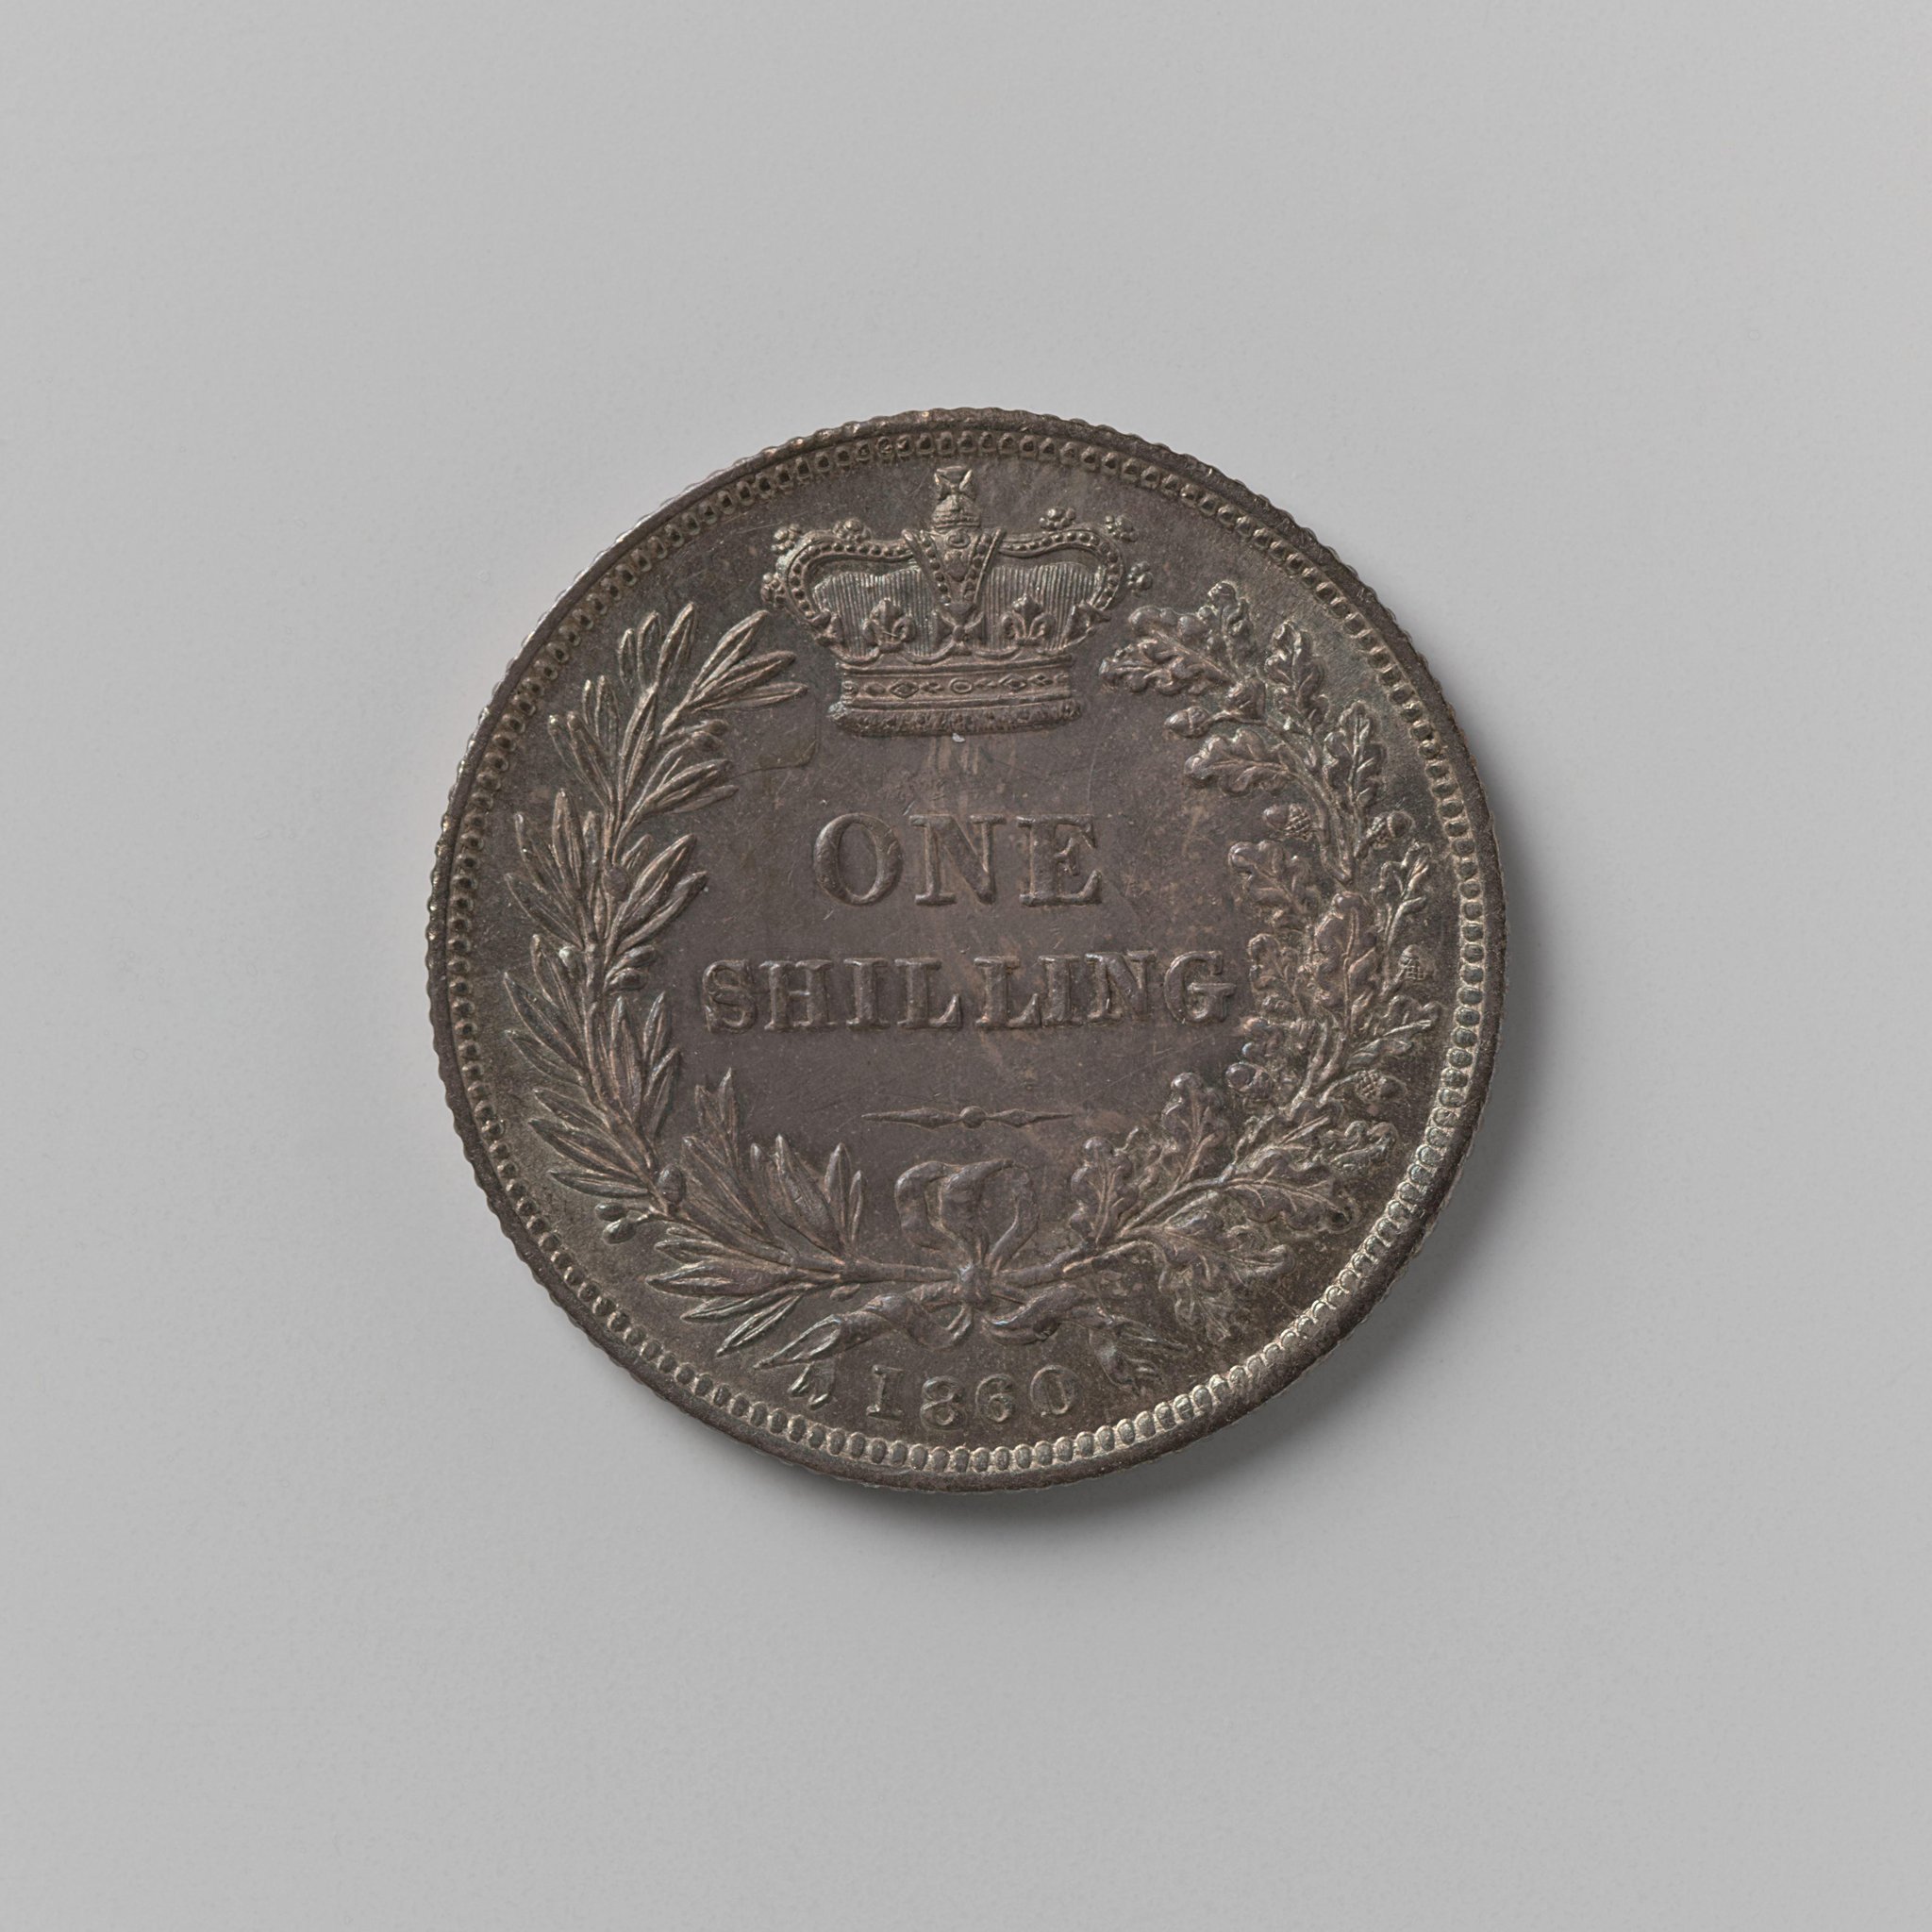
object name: coin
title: Engeland, Victoria, shilling, 1860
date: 1860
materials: silver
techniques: striking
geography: london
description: Zilveren munt. Voorzijde: gekroond hoofd van de koningin naar links [young head]. Keerzijde: binnen samengebonden laurier- en eikentak waarde-aanduiding in twee regels. Daarboven kroon. Jaartal onderaan. Kartelrand.